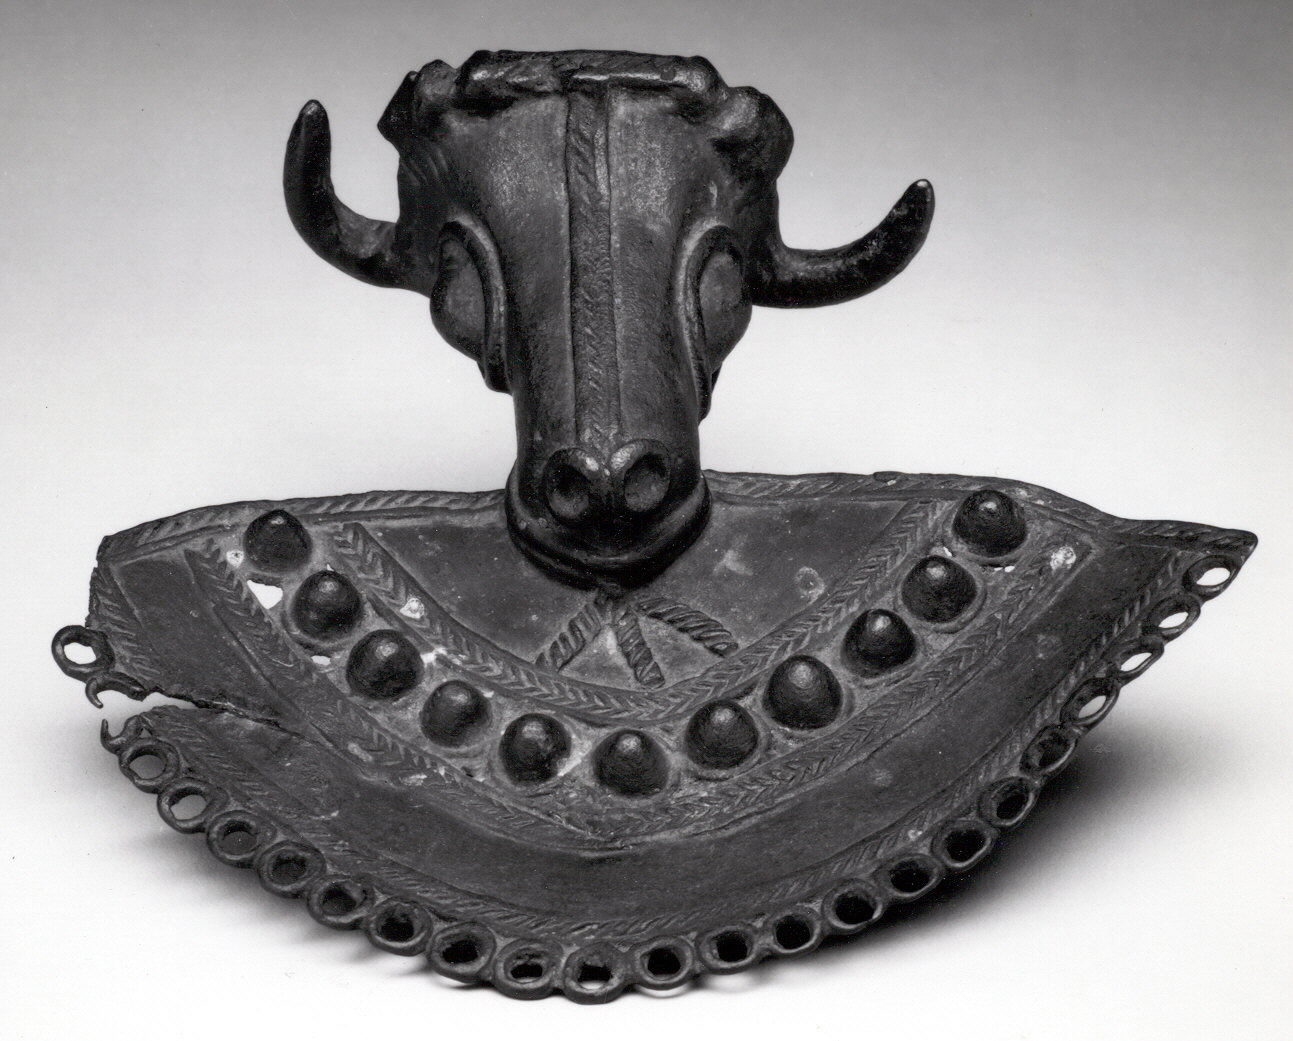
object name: pendant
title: Pendant: Ram Head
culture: edo period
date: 1601-1900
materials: brass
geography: nigeria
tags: rams